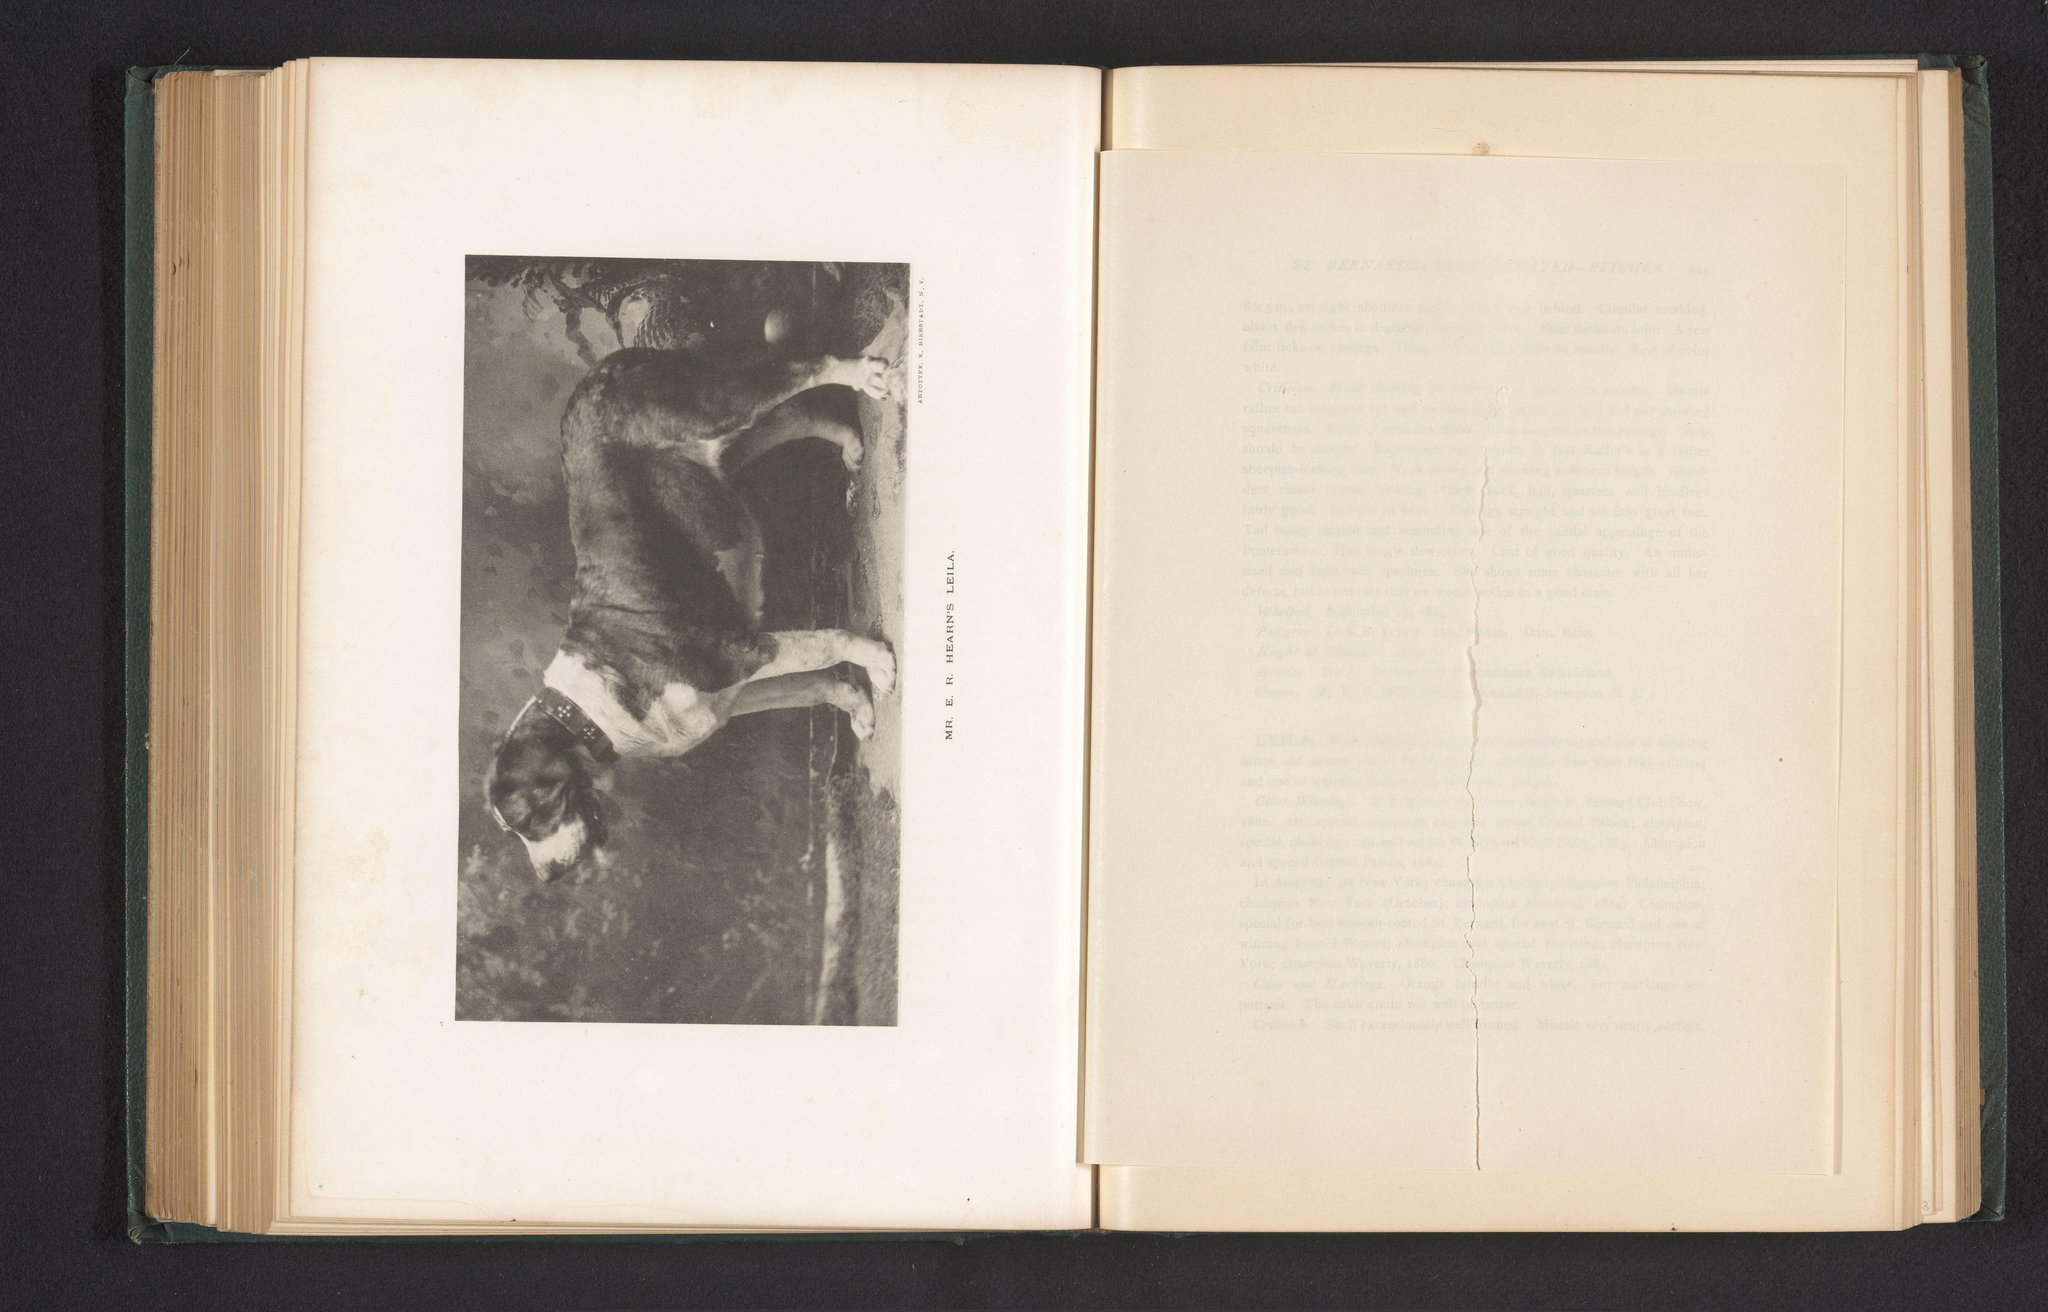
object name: photomechanical print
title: Sint-bernard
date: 1883-1888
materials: paper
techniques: photograph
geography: new york city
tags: dog (st.bernard)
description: Prent tegenover pagina 325, achter semi-transparante omslag.